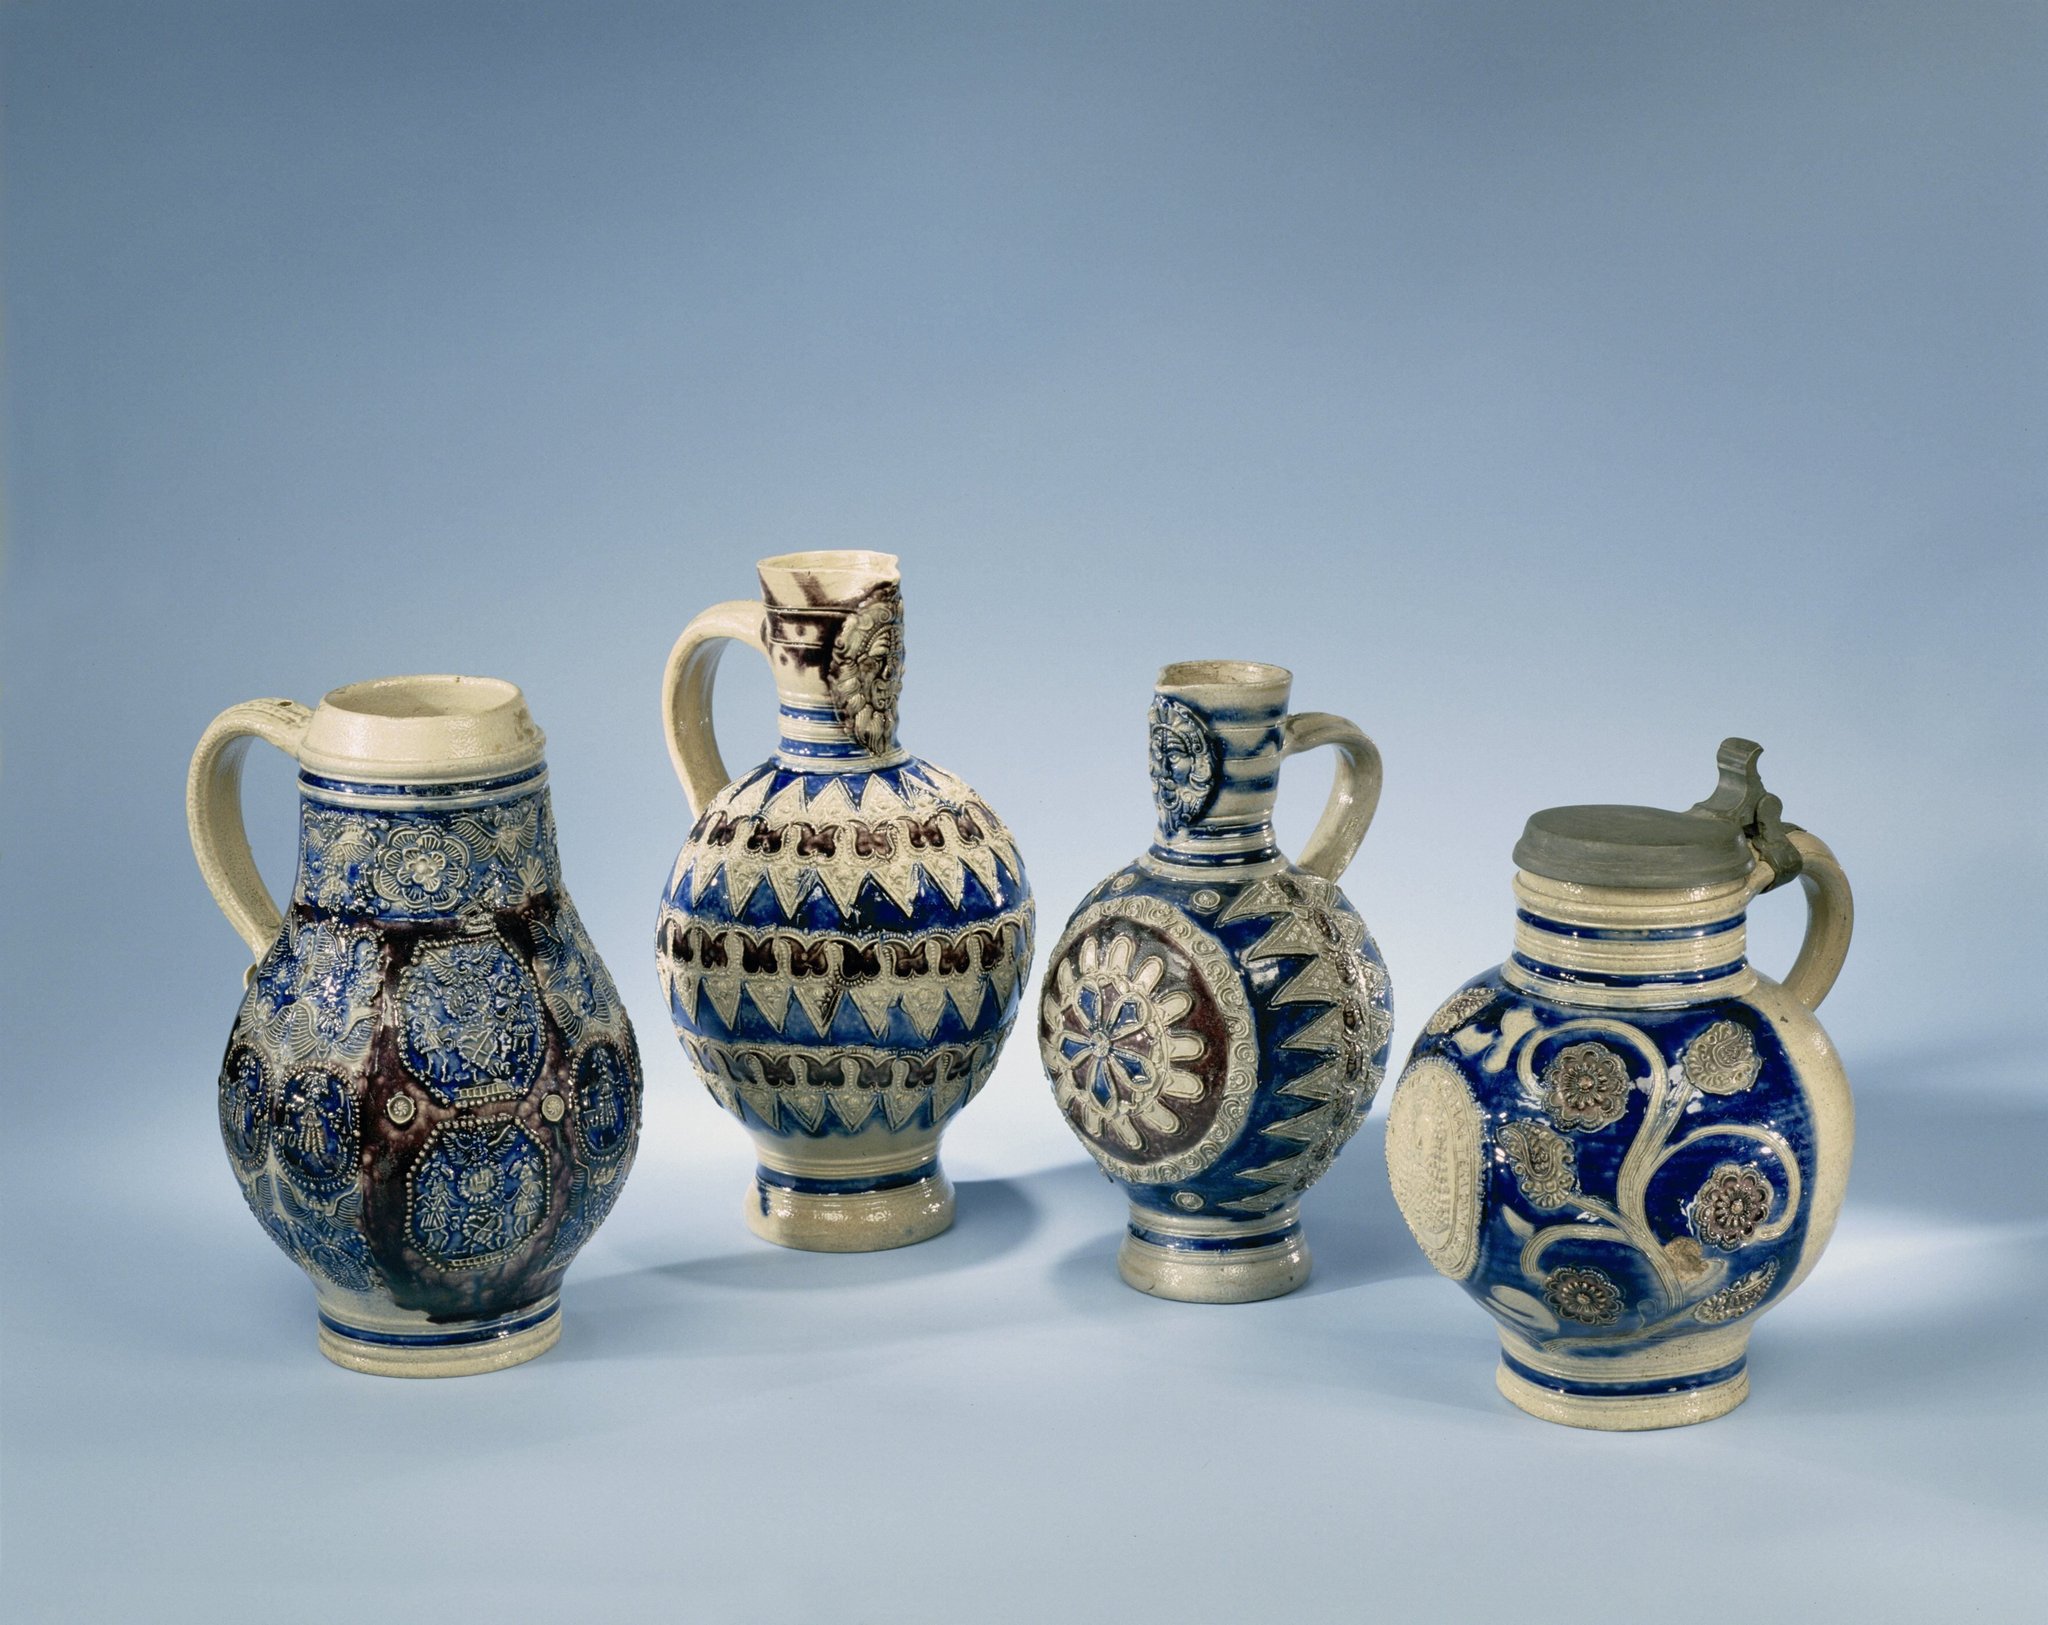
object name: ewer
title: Jug with masks and stylized foliate ornamentation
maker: Anonymous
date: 1650-1699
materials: cobalt, glaze, mineral, stoneware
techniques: firing, forming, relief, turning, vitrification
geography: westerwald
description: Kan van steengoed op hoge voet met een eivormige buik en een smalle hals met geknepen tuit. Het C-vormige oor is bevestigd aan de nek en de schouder. Enkele ingegrifte lijnen op de voet en de nek. Gedeeltelijk bedekt met kobaltblauw en mangaanpaars. Op de nek een reliëfdecoratie met een gedrukt, opgelegd masker van een baardman of een leeuw. De voorzijde van de buik met concentrische cirkels van bloemranken en een bloemrozet. Om het handvat een leeg medaillon. De zijkanten met een verticale lijn van kleine maskers met aan weerszijden driehoekige bladmotieven. Westerwald.